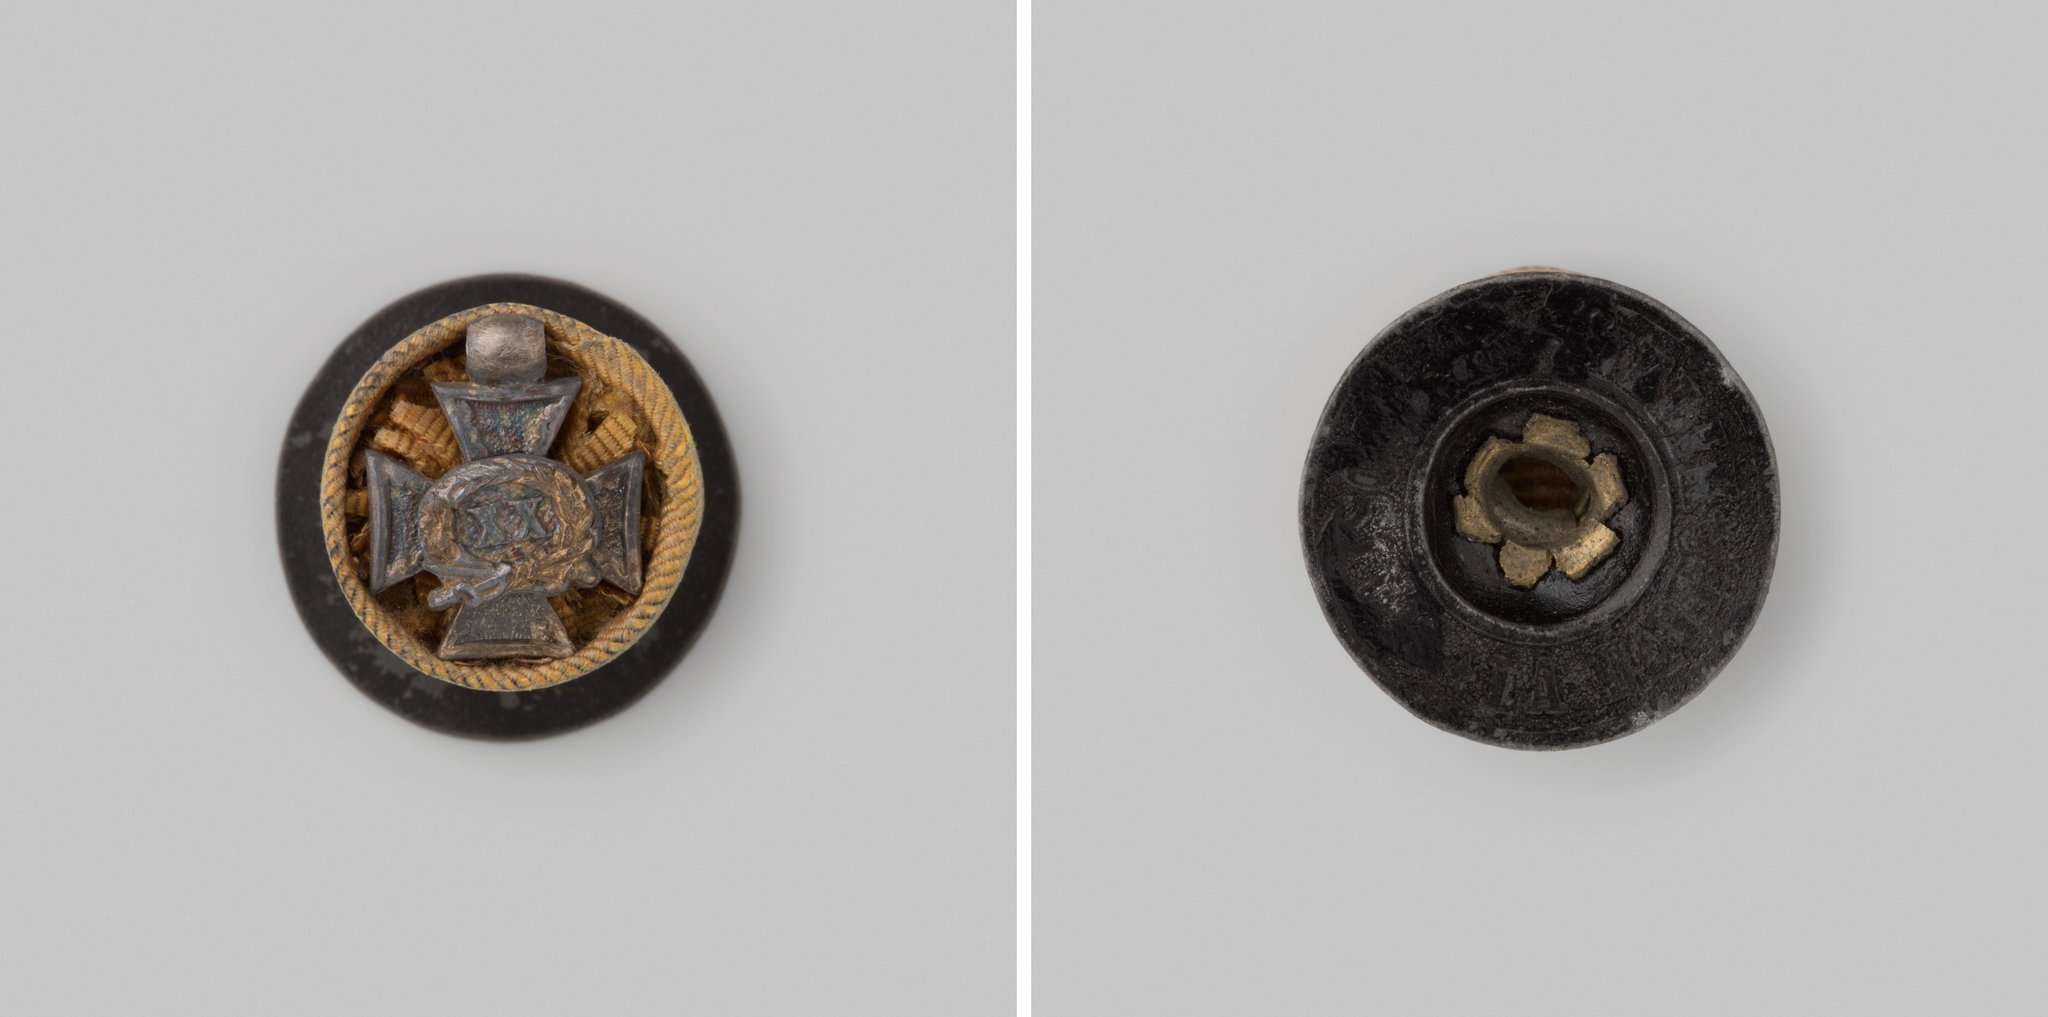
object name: ereteken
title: Ereteken voor twintigjarige dienst als officier bij de schutterij te Amsterdam, gedragen door A. Mendes da Costa, luitenant-kolonel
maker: Anonymous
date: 1892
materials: silver, textile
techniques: gilding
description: Zilveren draagpenning in de vorm van een rozet, met verguldsel, gevat in stoffen omhulsel en met knop aan de achterzijde